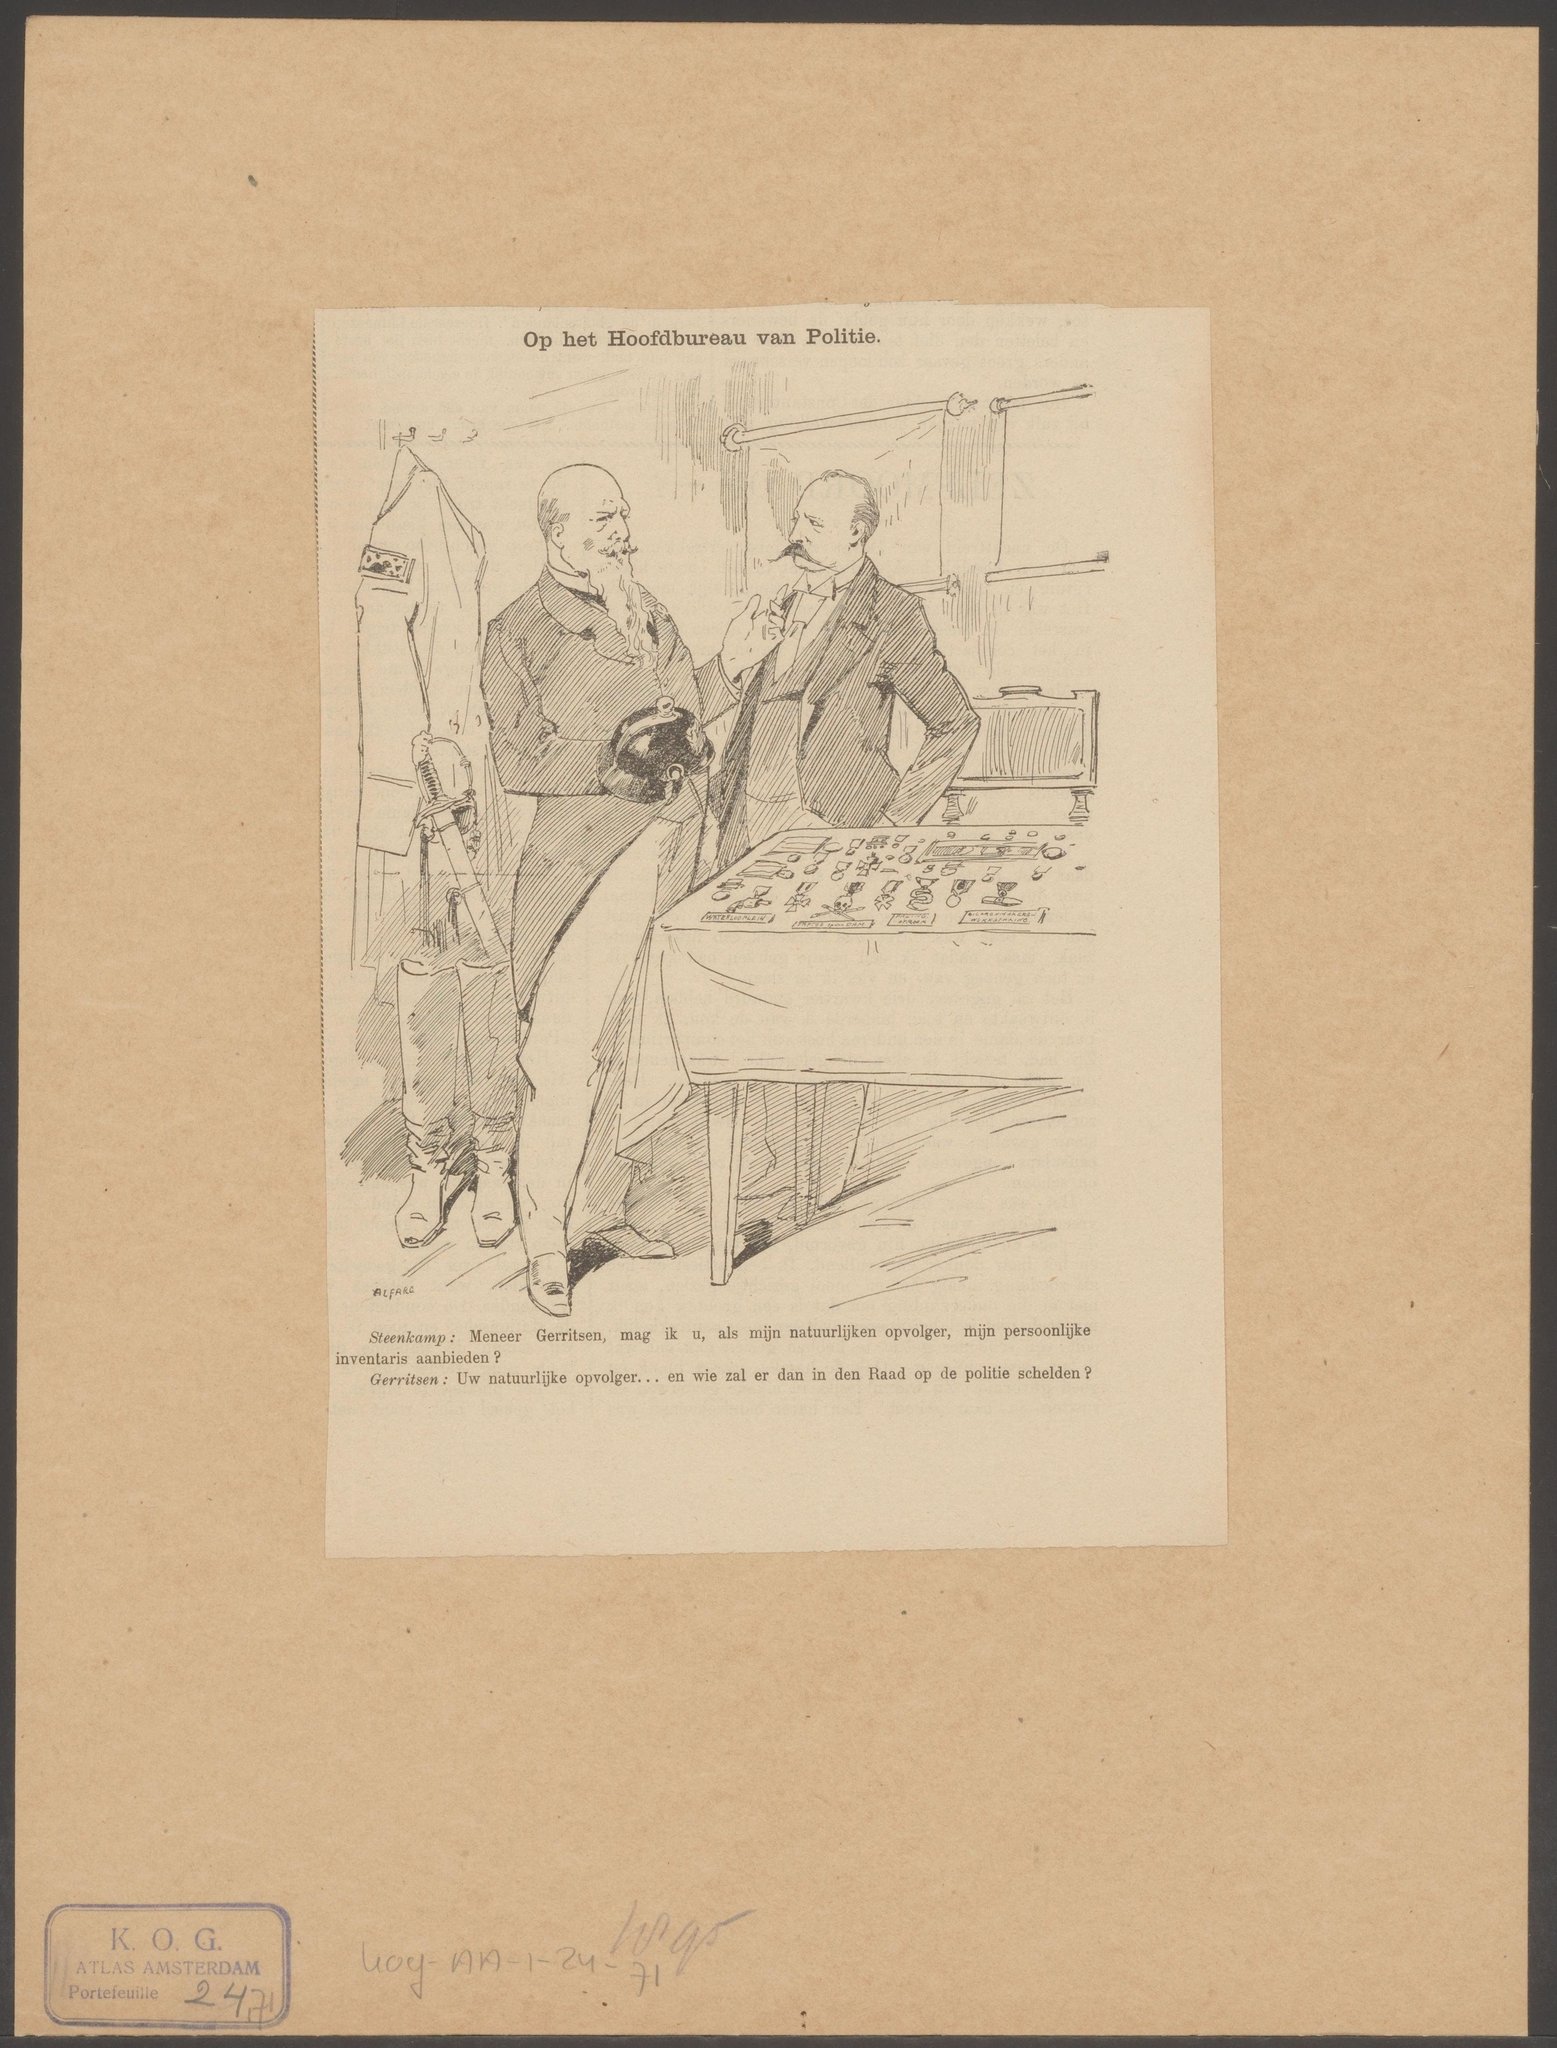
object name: cartoon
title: Pieter Willem Steenkamp en Carel Victor Gerritsen in gesprek bij een tafel met onderscheidingen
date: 1895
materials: paper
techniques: letterpress printing, line block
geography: netherlands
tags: politician, medals and other marks of military honour, conversation, dialogue; conversation piece, police, amsterdam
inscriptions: collector's mark: Lugt 1641b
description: Onderwerpsrubriek binnen de Atlas Amsterdam: Politie.